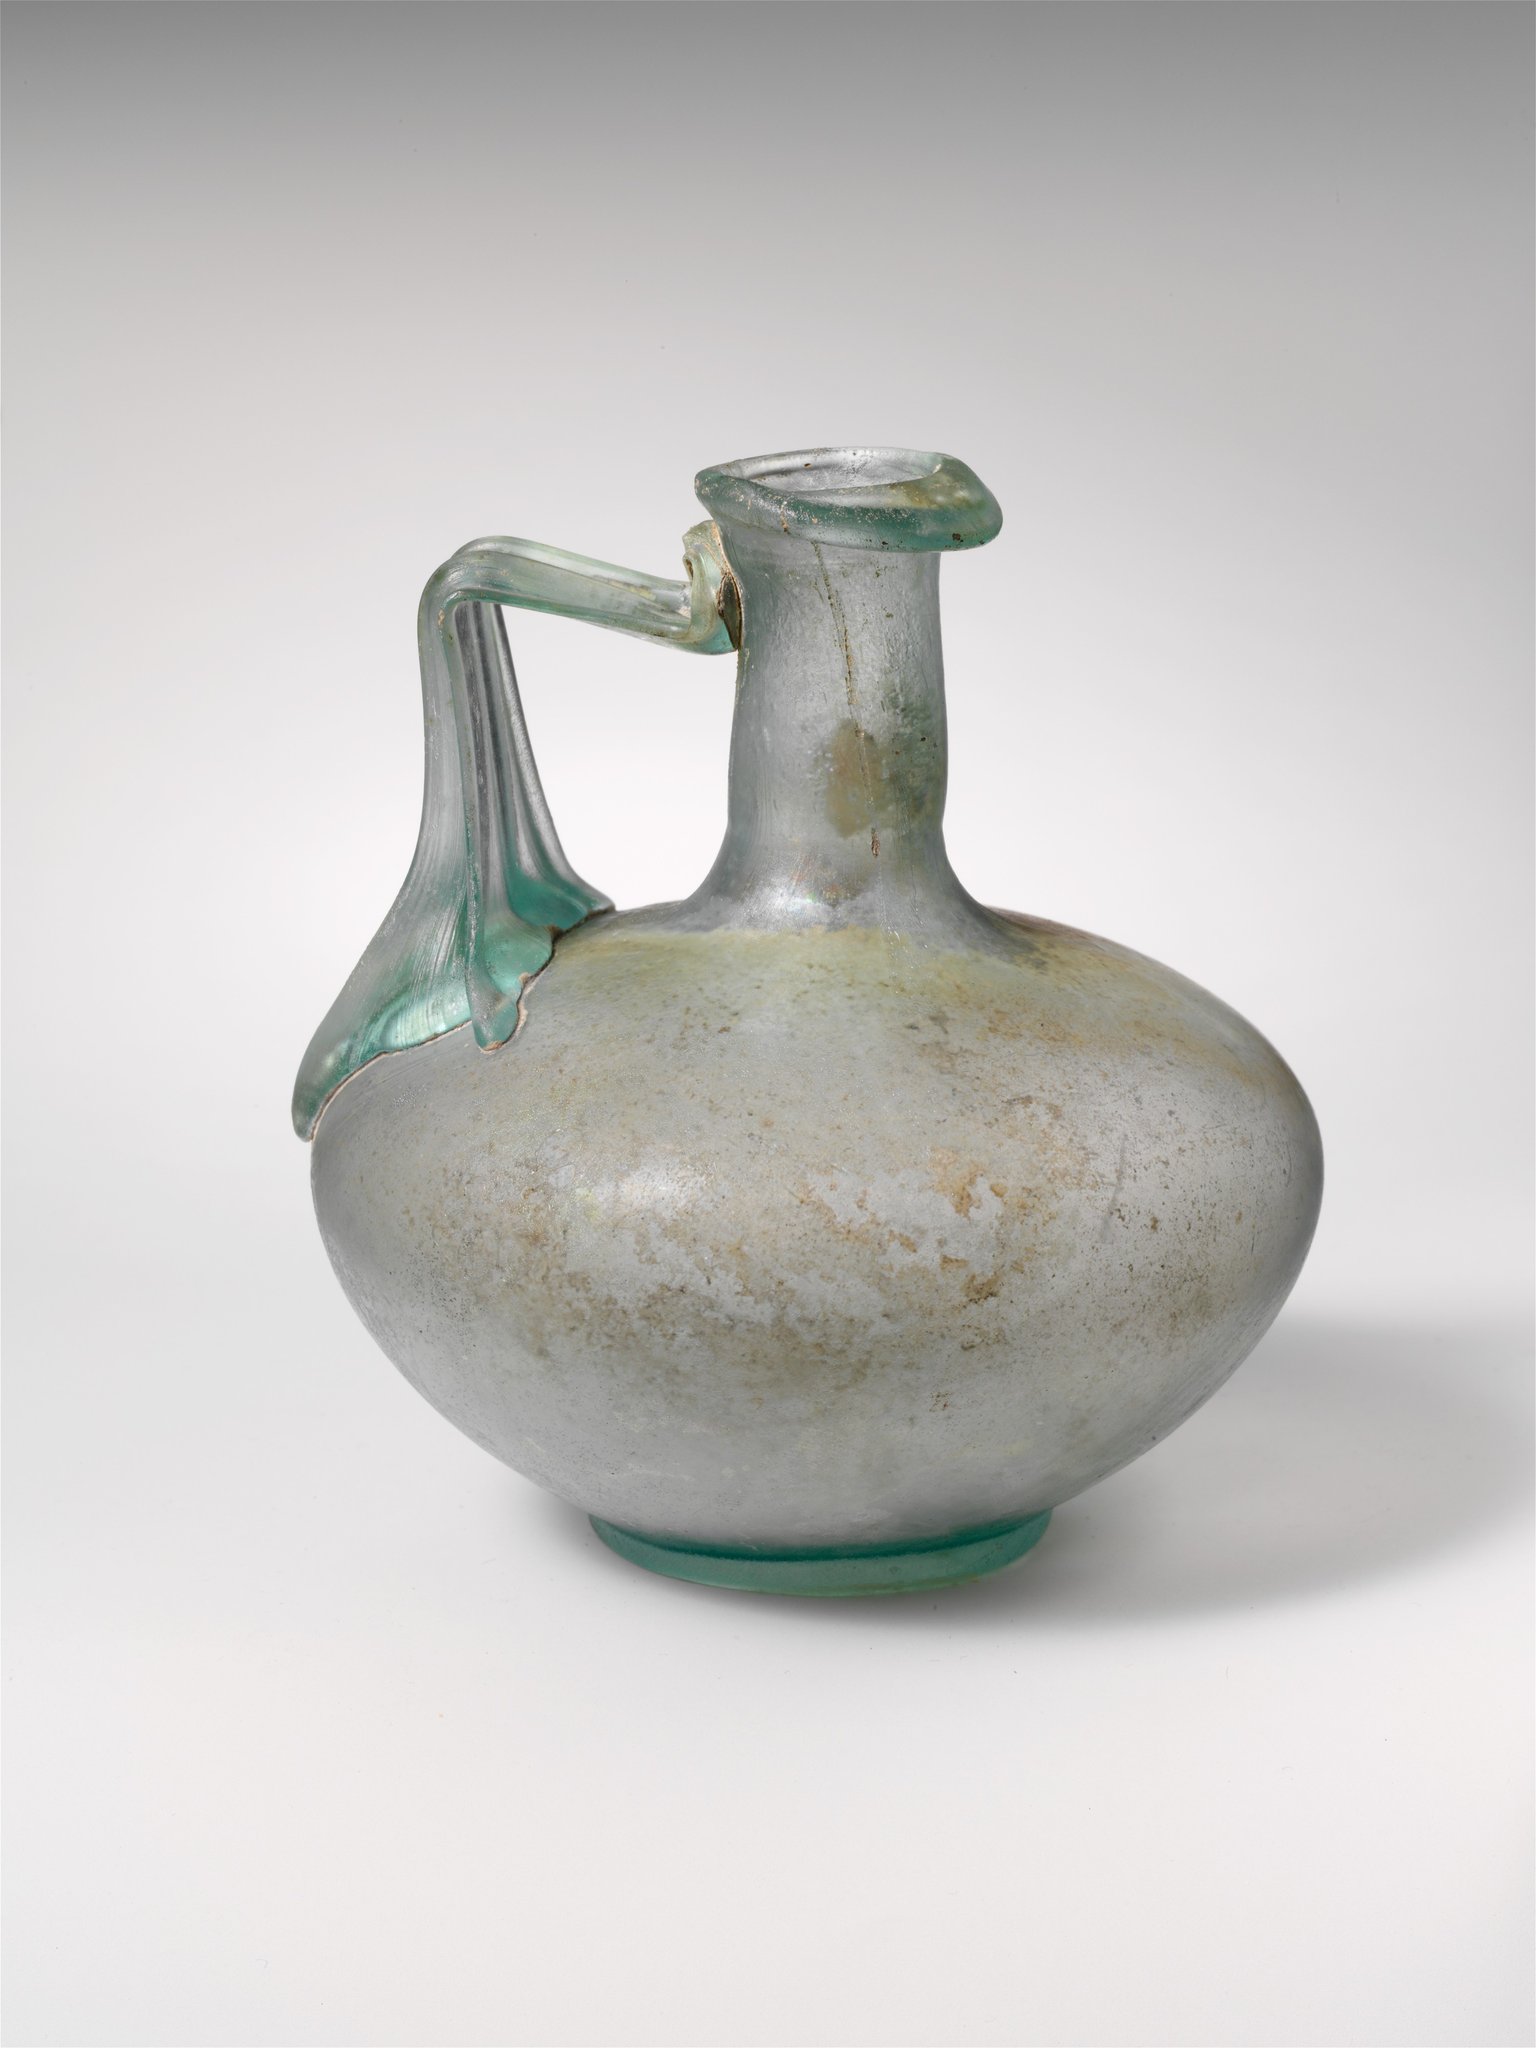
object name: jug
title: Glass jug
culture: roman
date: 1-200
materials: glass